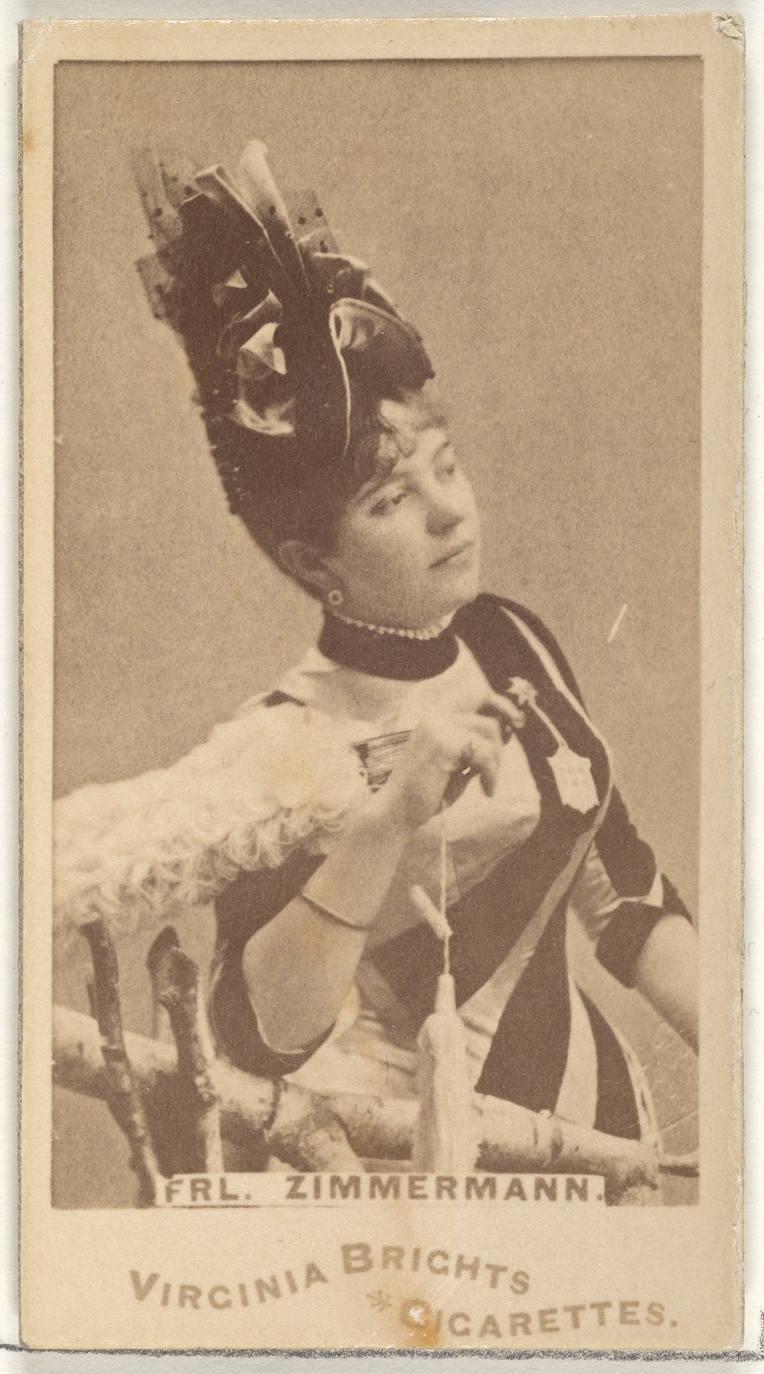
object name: photograph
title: Fräulein Zimmermann, from the Actors and Actresses series (N45, Type 1) for Virginia Brights Cigarettes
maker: allen & ginter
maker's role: publisher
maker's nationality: american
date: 1888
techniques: albumen silver print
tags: portraits,women,actresses